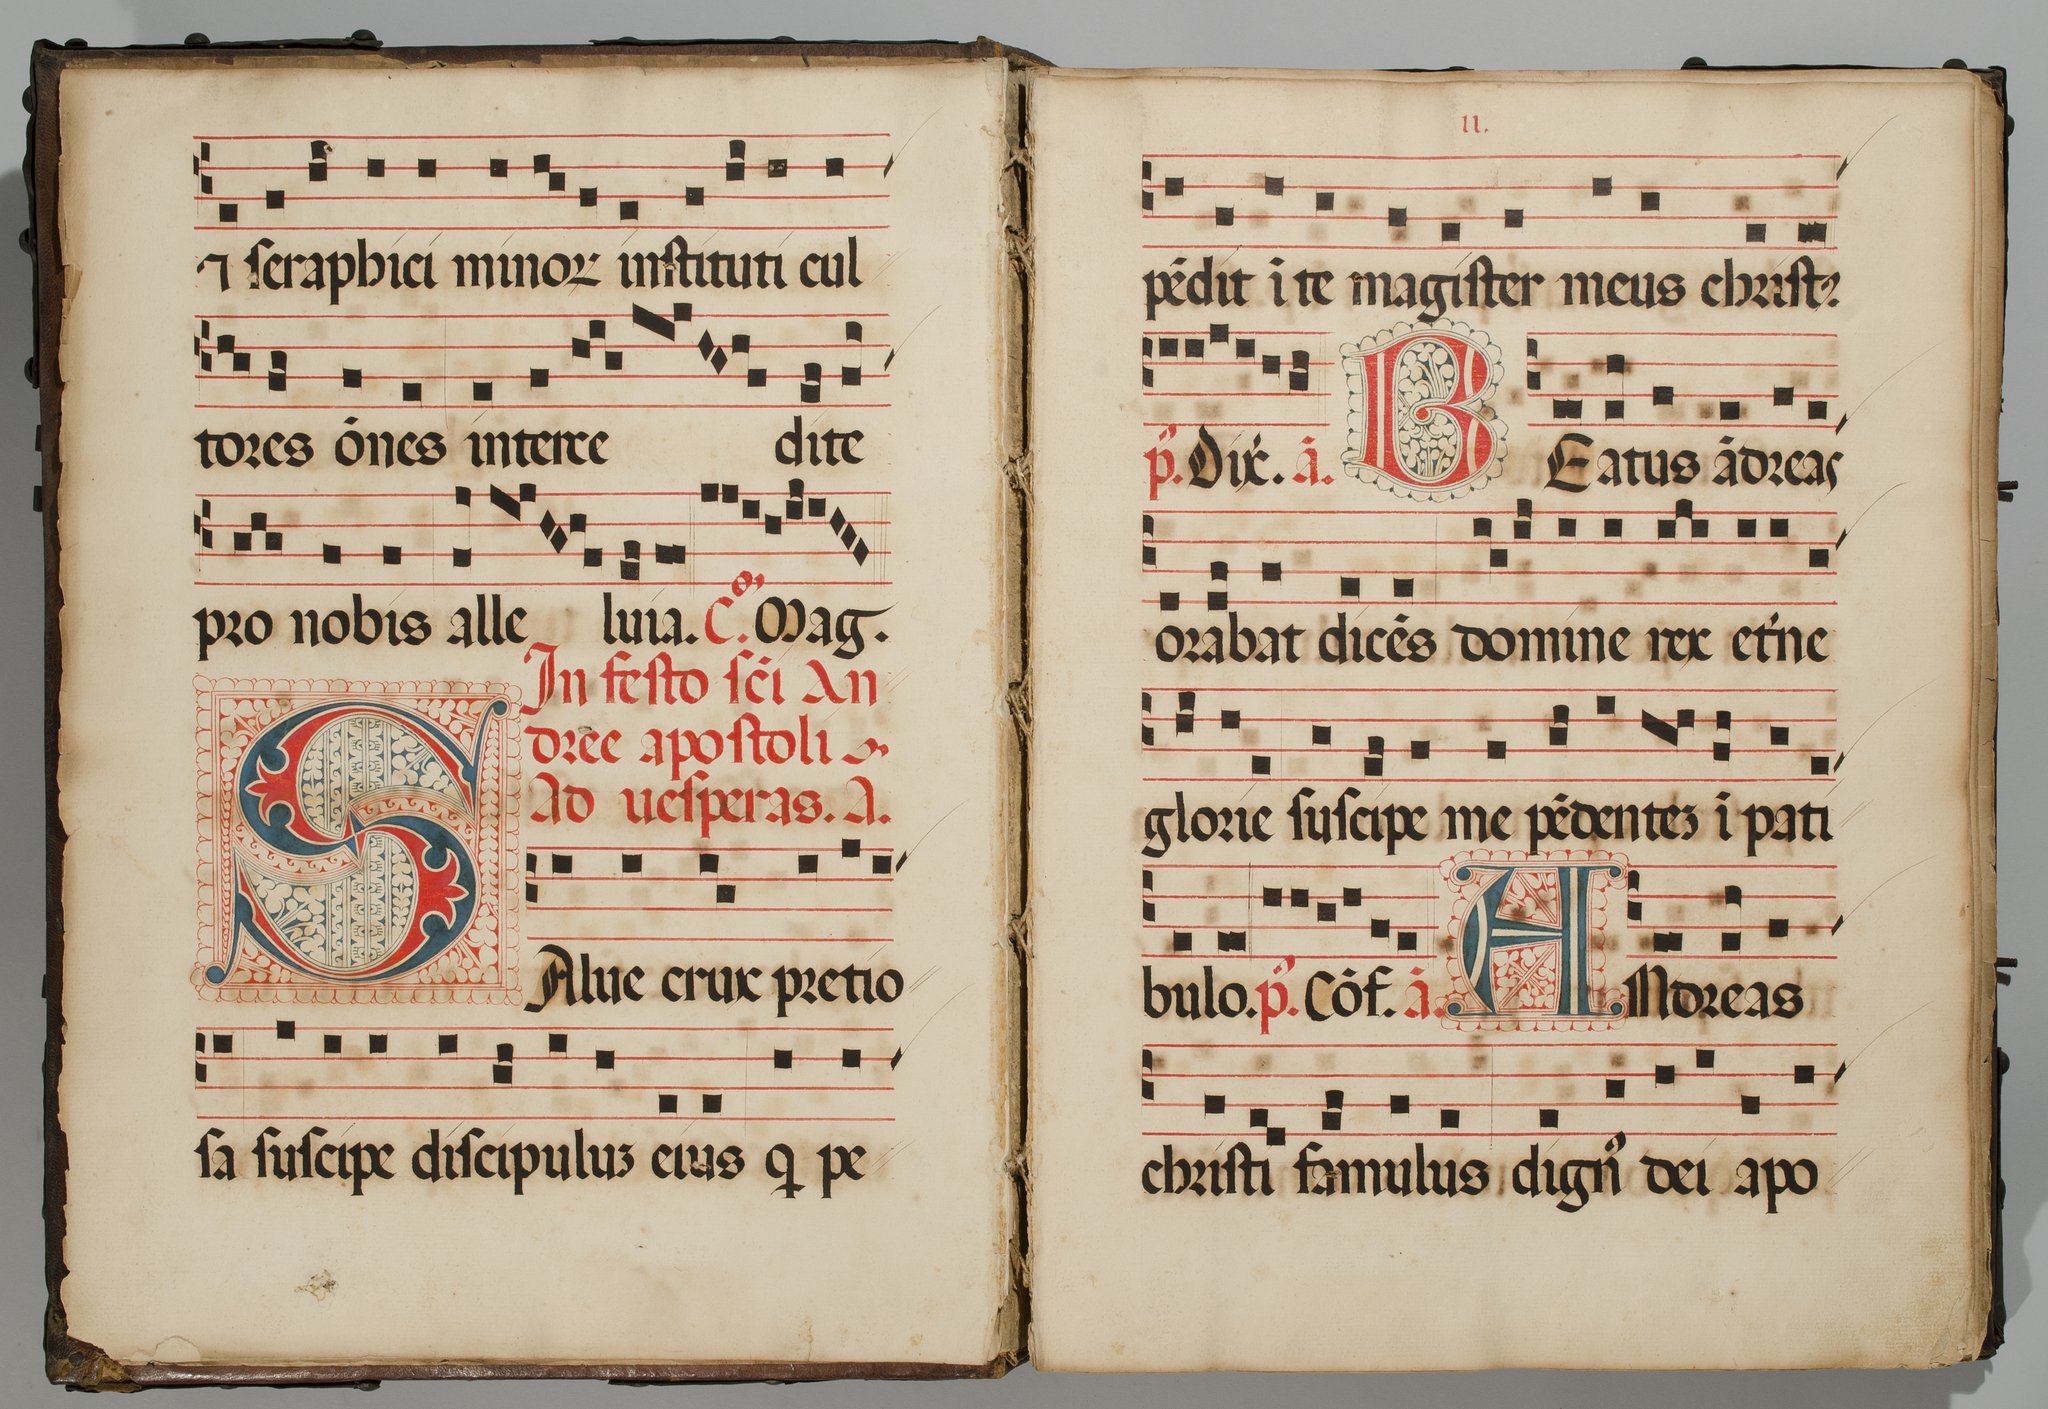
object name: antiphonary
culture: italian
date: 1736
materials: leather, paper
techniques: bookbinding